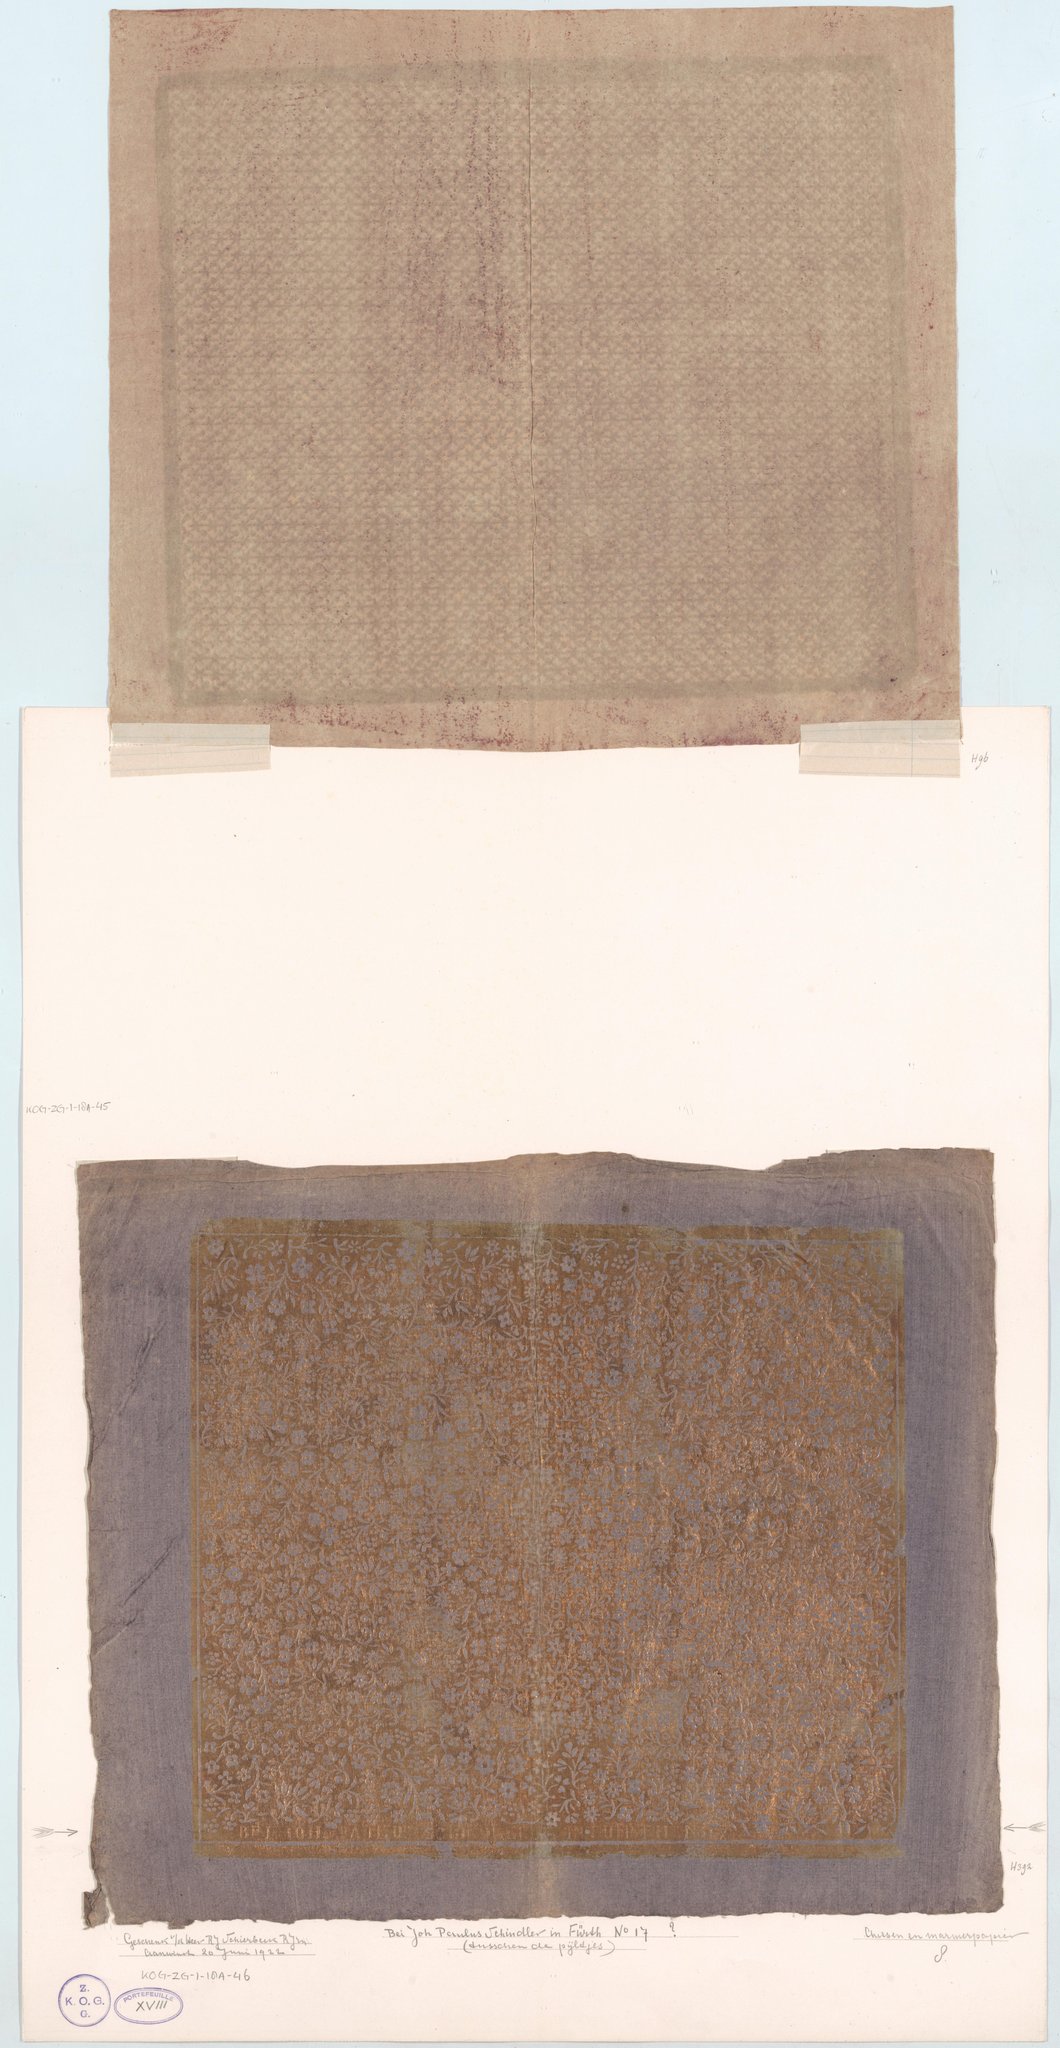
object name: brocade paper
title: Blad met een patroon van bloemen en bladeren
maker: Anonymous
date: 1750-1800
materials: gold leaf, paint, paper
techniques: relief print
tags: stars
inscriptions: collector's mark: Lugt 1641, stamp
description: Blad met een patroon van bloemen en bladeren. Onderwerpsrubrieken binnen de Atlas Zeden en Gewoonten: Schoone kunsten, Sitsen en marmerpapier.